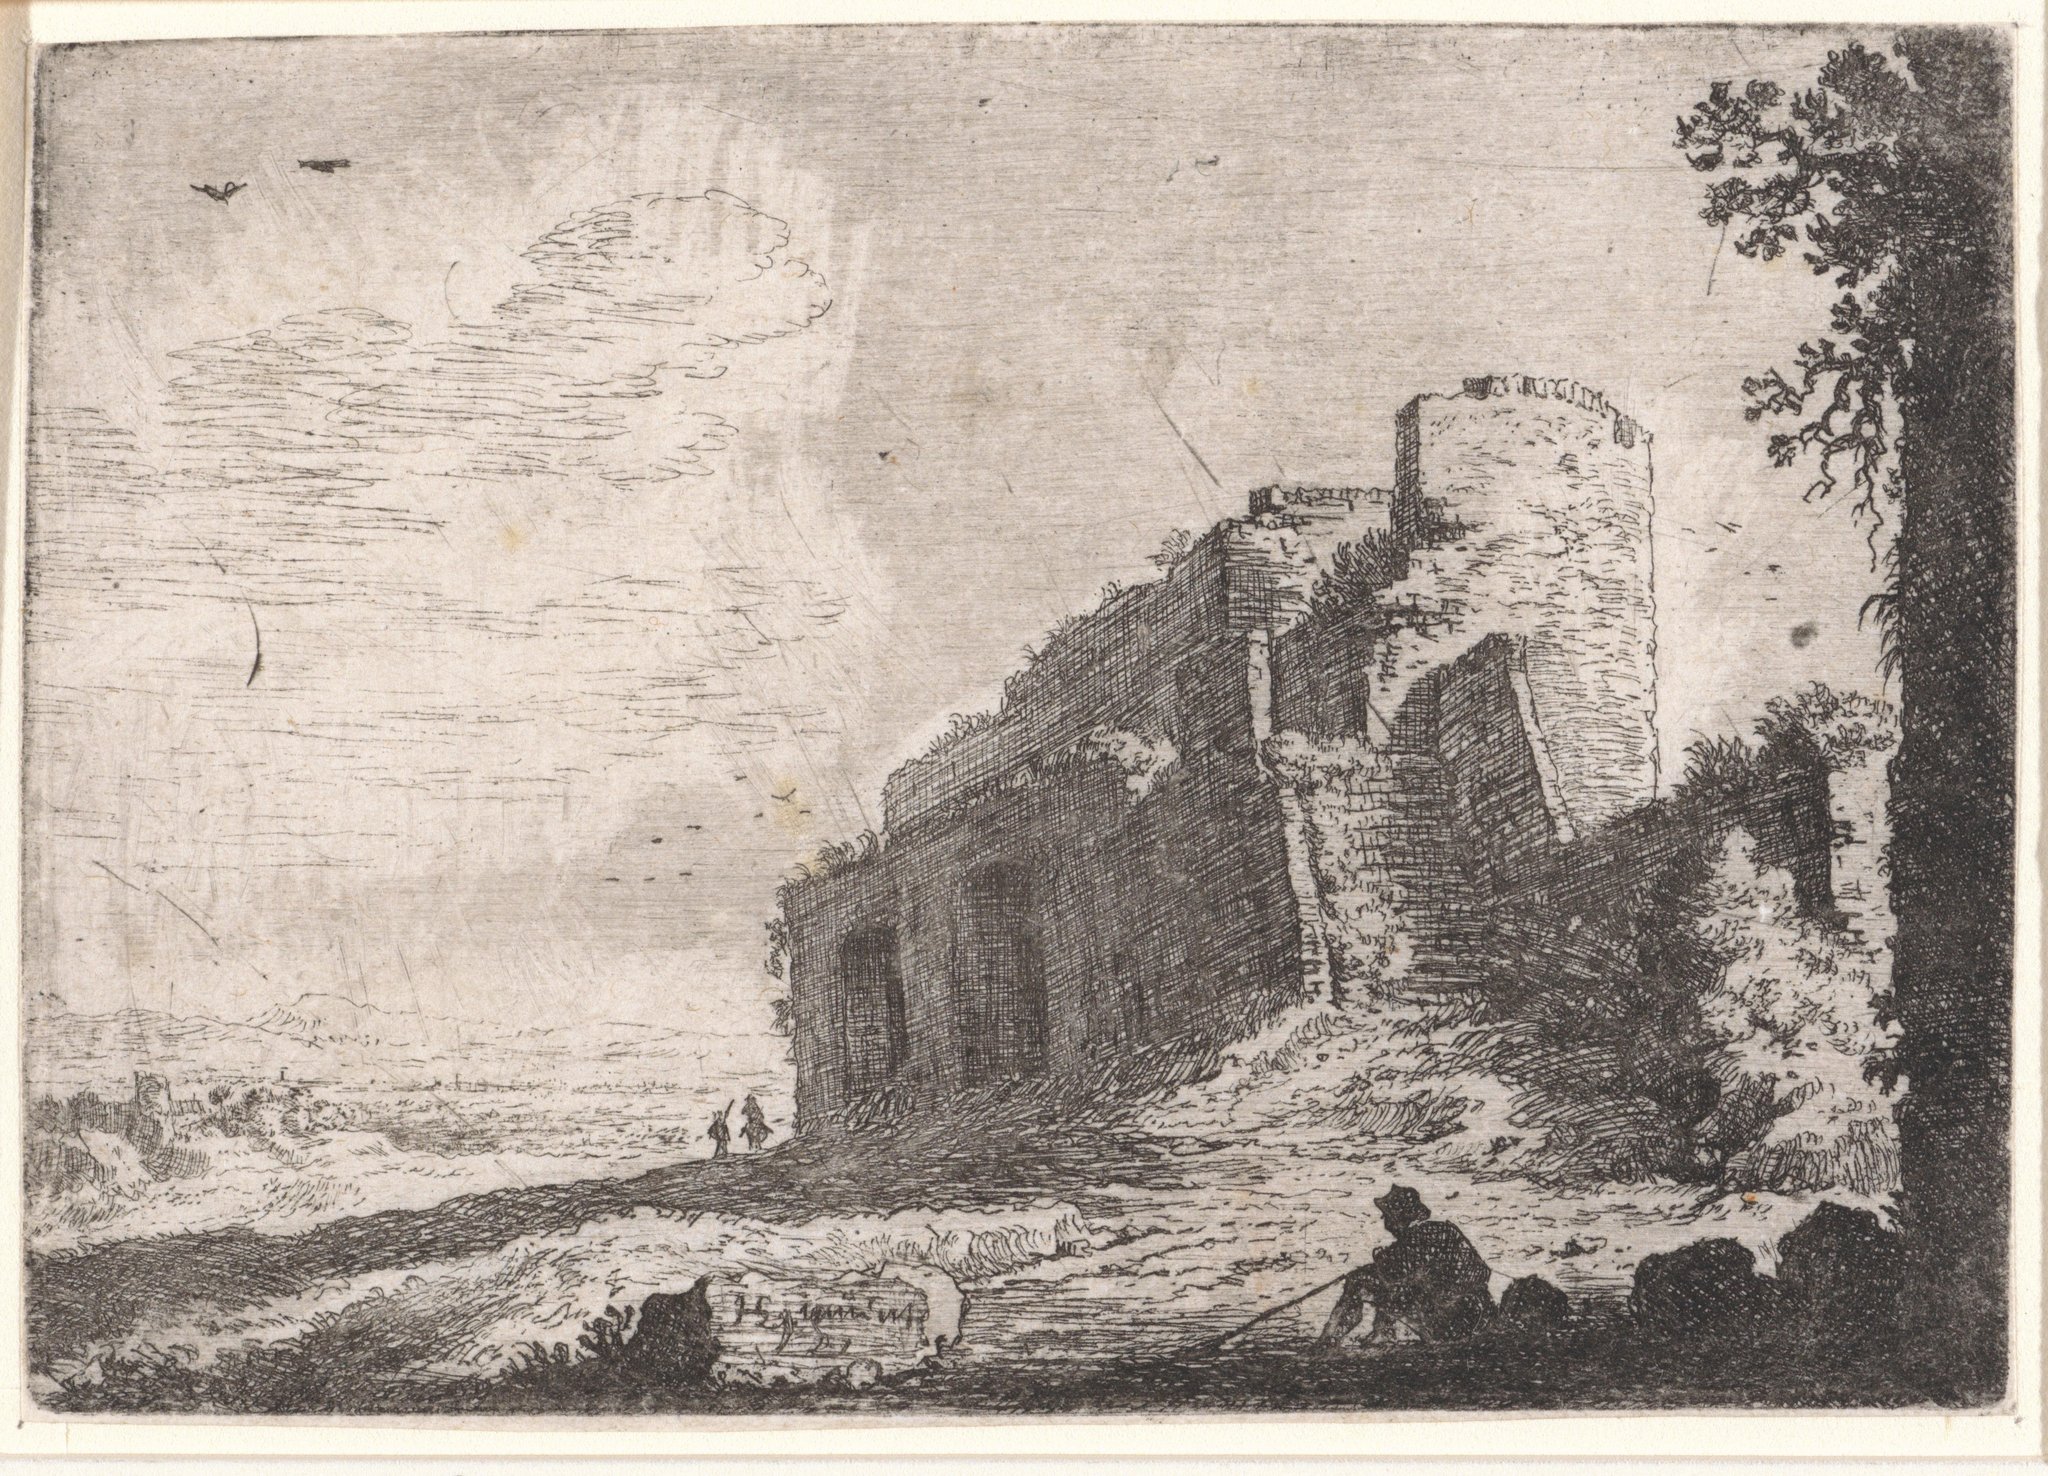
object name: print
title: Rotsachtige landschappen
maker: herman saftleven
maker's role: draughtsman, painter, print maker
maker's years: 1609-1685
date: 1626-1685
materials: paper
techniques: etching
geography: utrecht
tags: landscape with ruins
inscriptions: collector's mark: Lugt 240